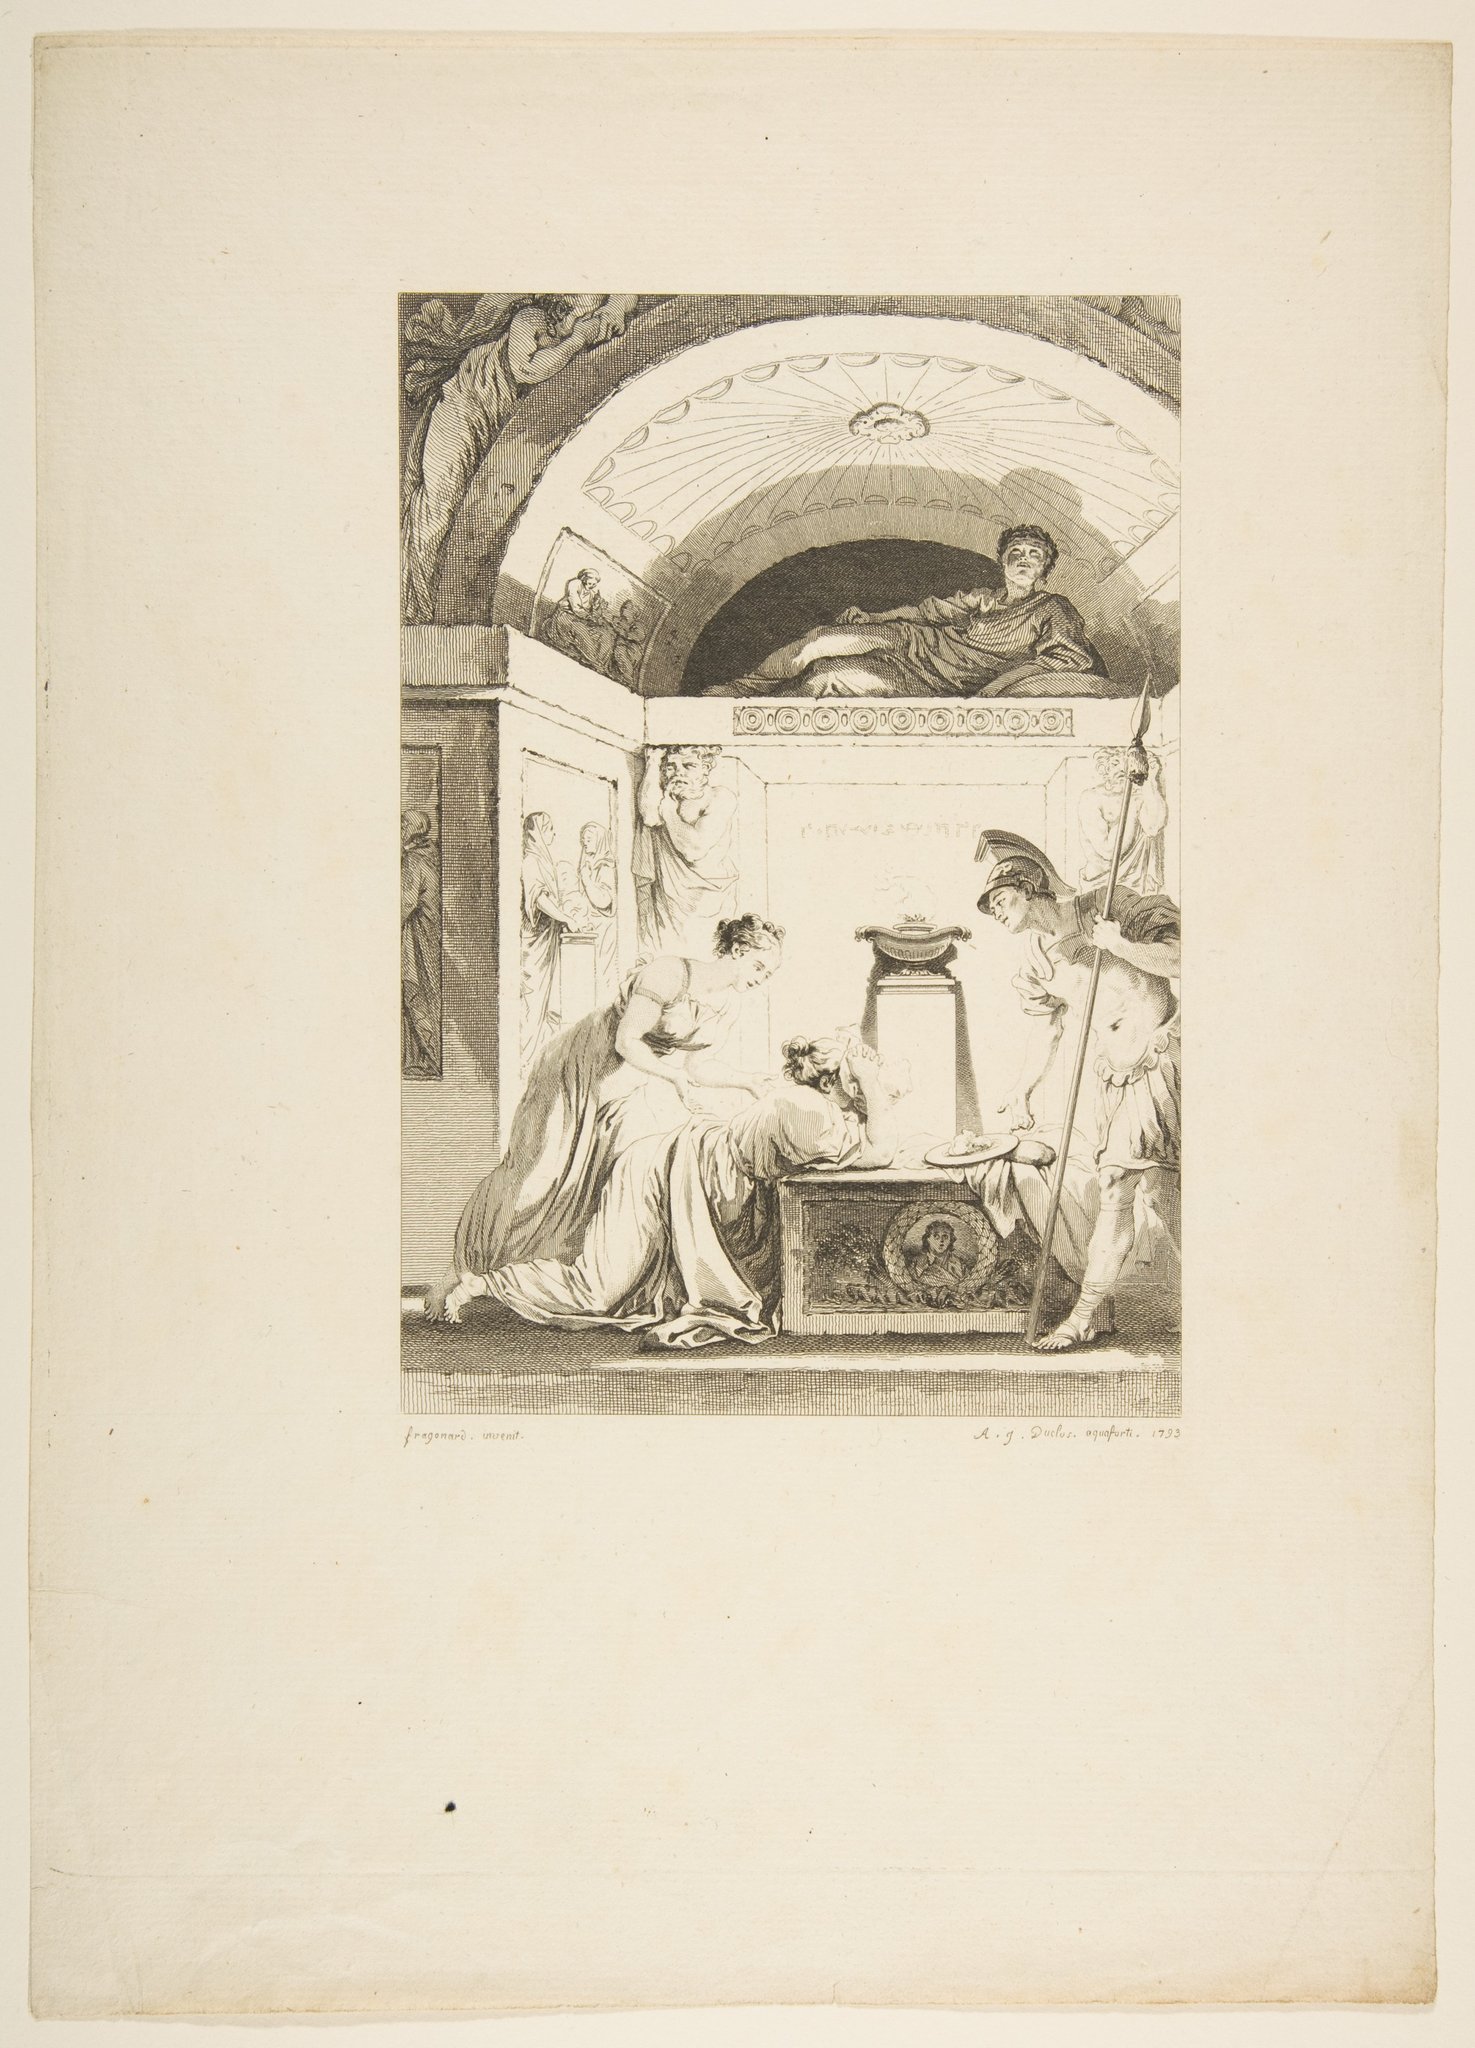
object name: print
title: La Matrone d'Ephese, from "Contes et nouvelles en vers par Jean de La Fontaine. A Paris, de l'imprimerie de P. Didot, l'an III de la République, 1795"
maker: jean-louis delignon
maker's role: artist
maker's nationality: french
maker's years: 1755-1804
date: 1793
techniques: etching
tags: tombs,soldiers,spears,women